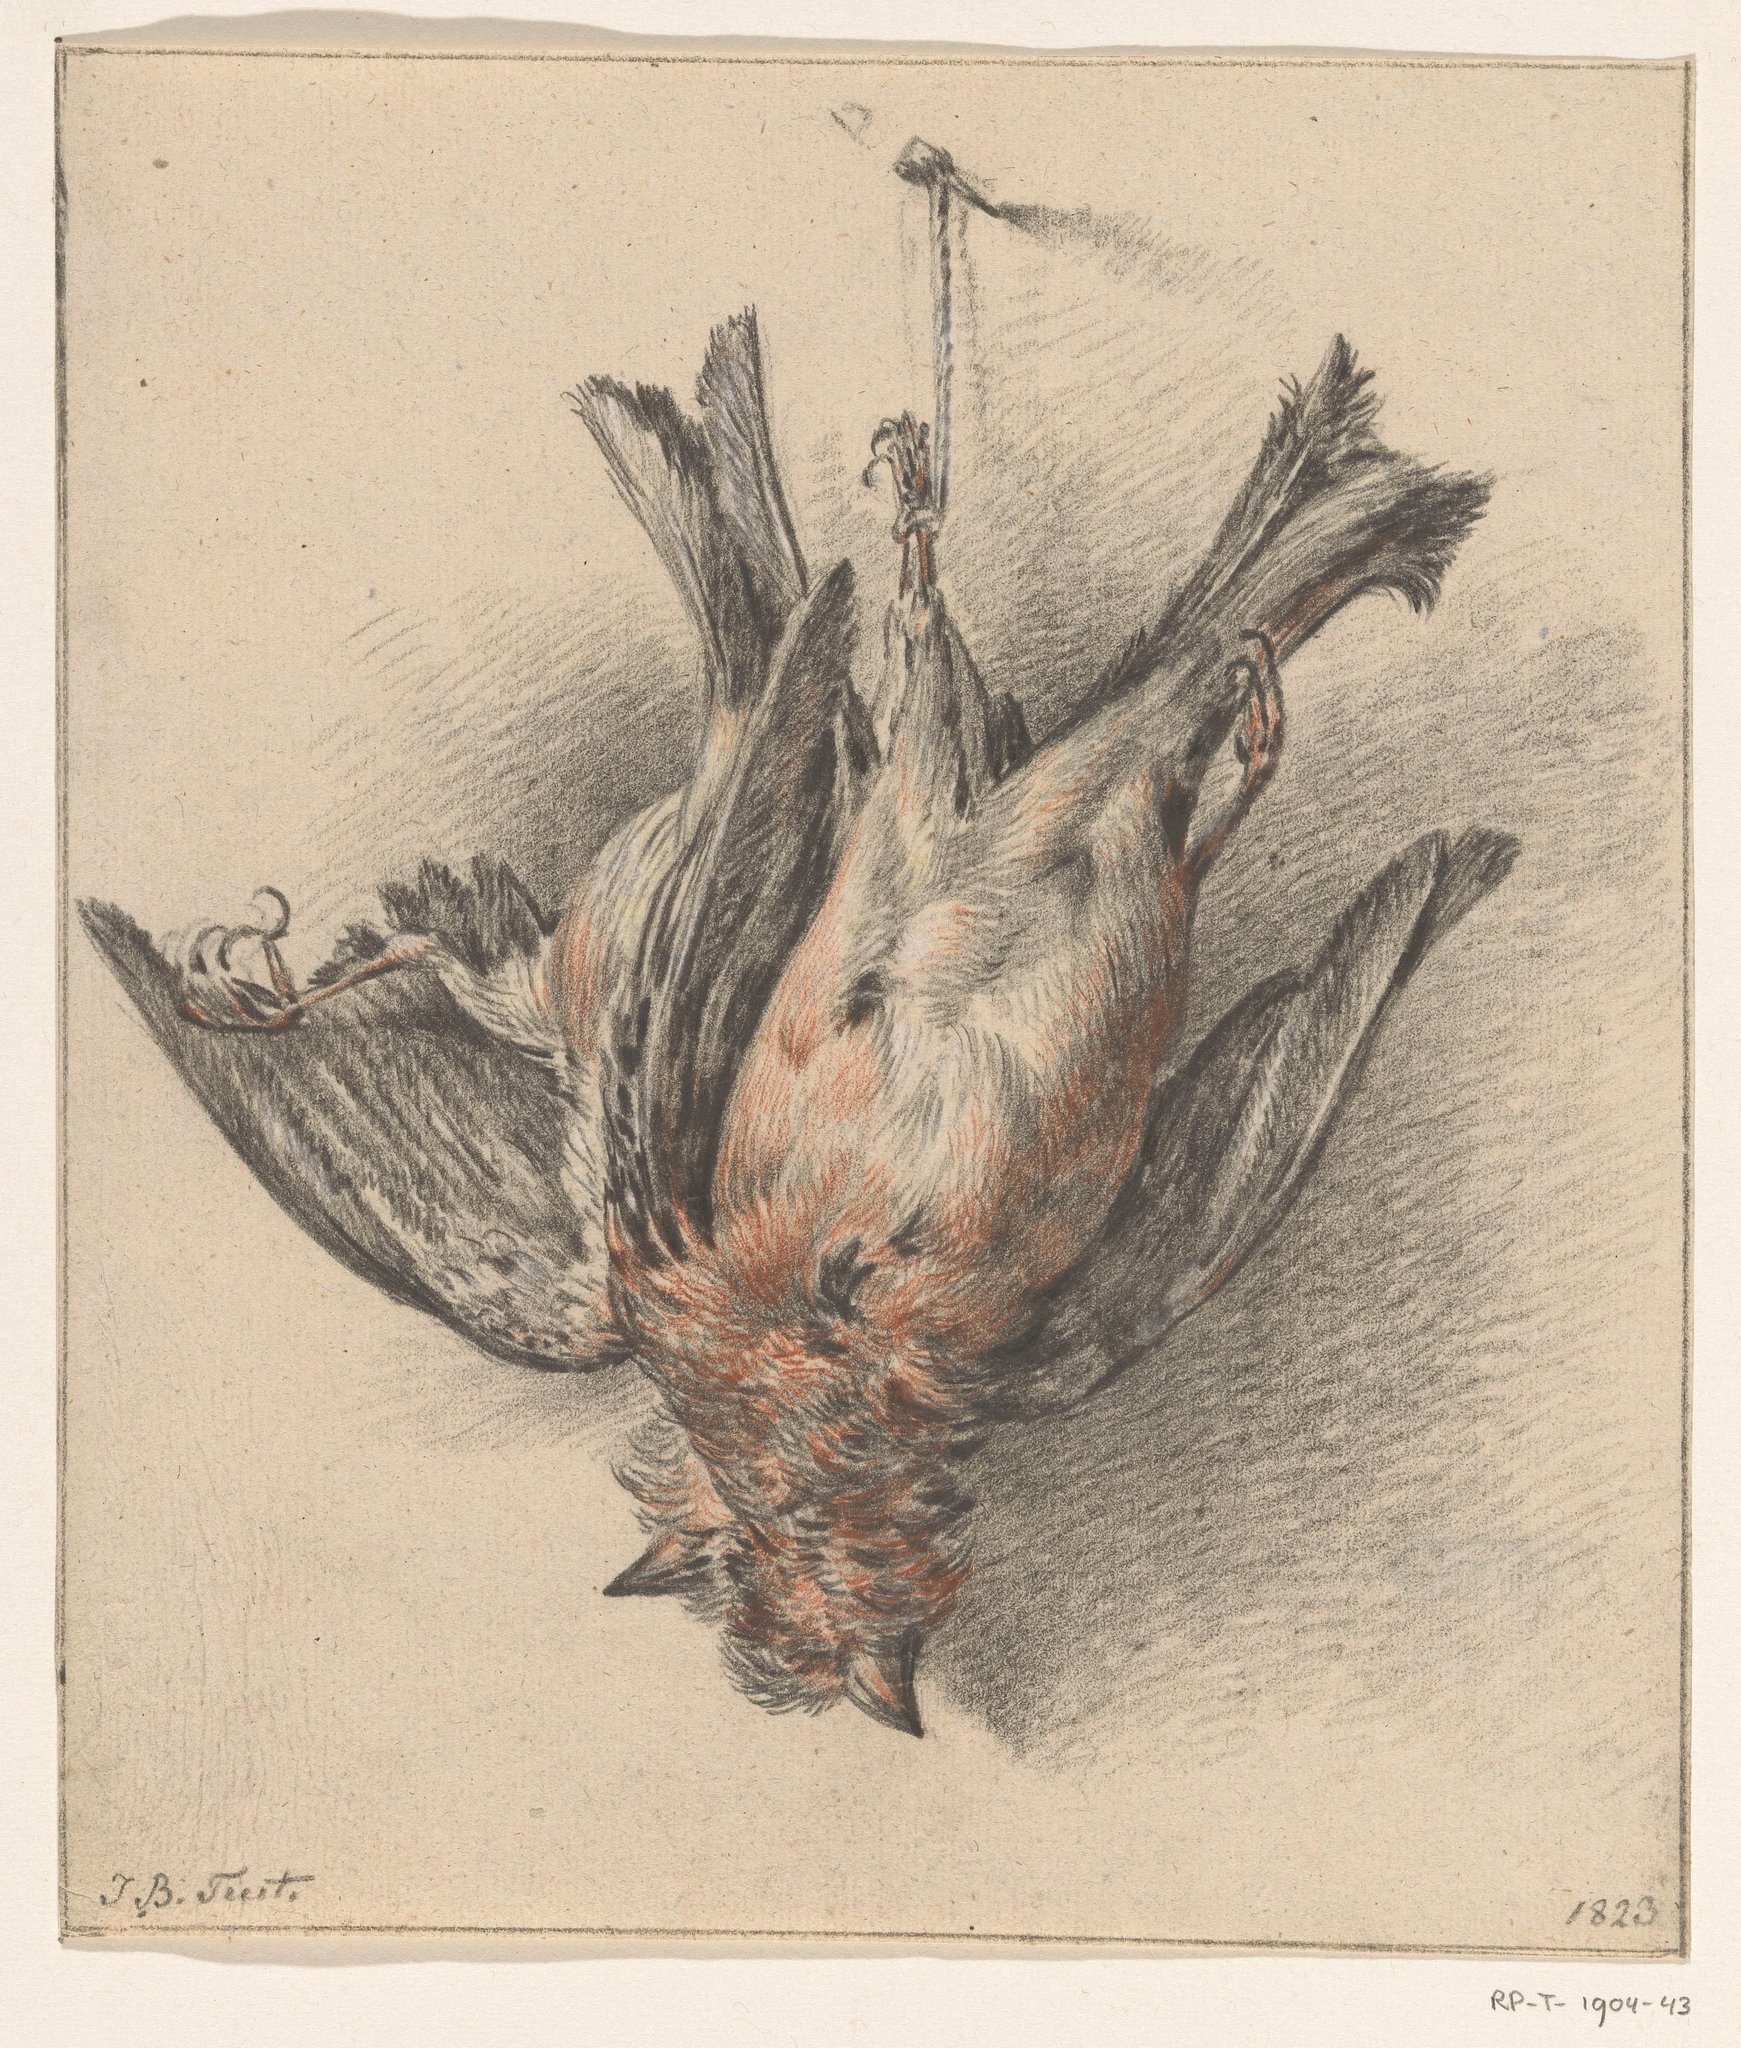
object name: drawing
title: Twee dode vogels, aan een touwtje afgehangen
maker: jean bernard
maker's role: draughtsman, print maker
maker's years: 1765-1833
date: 1823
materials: chalk, paper, pencil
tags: birds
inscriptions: date: ‘1823’